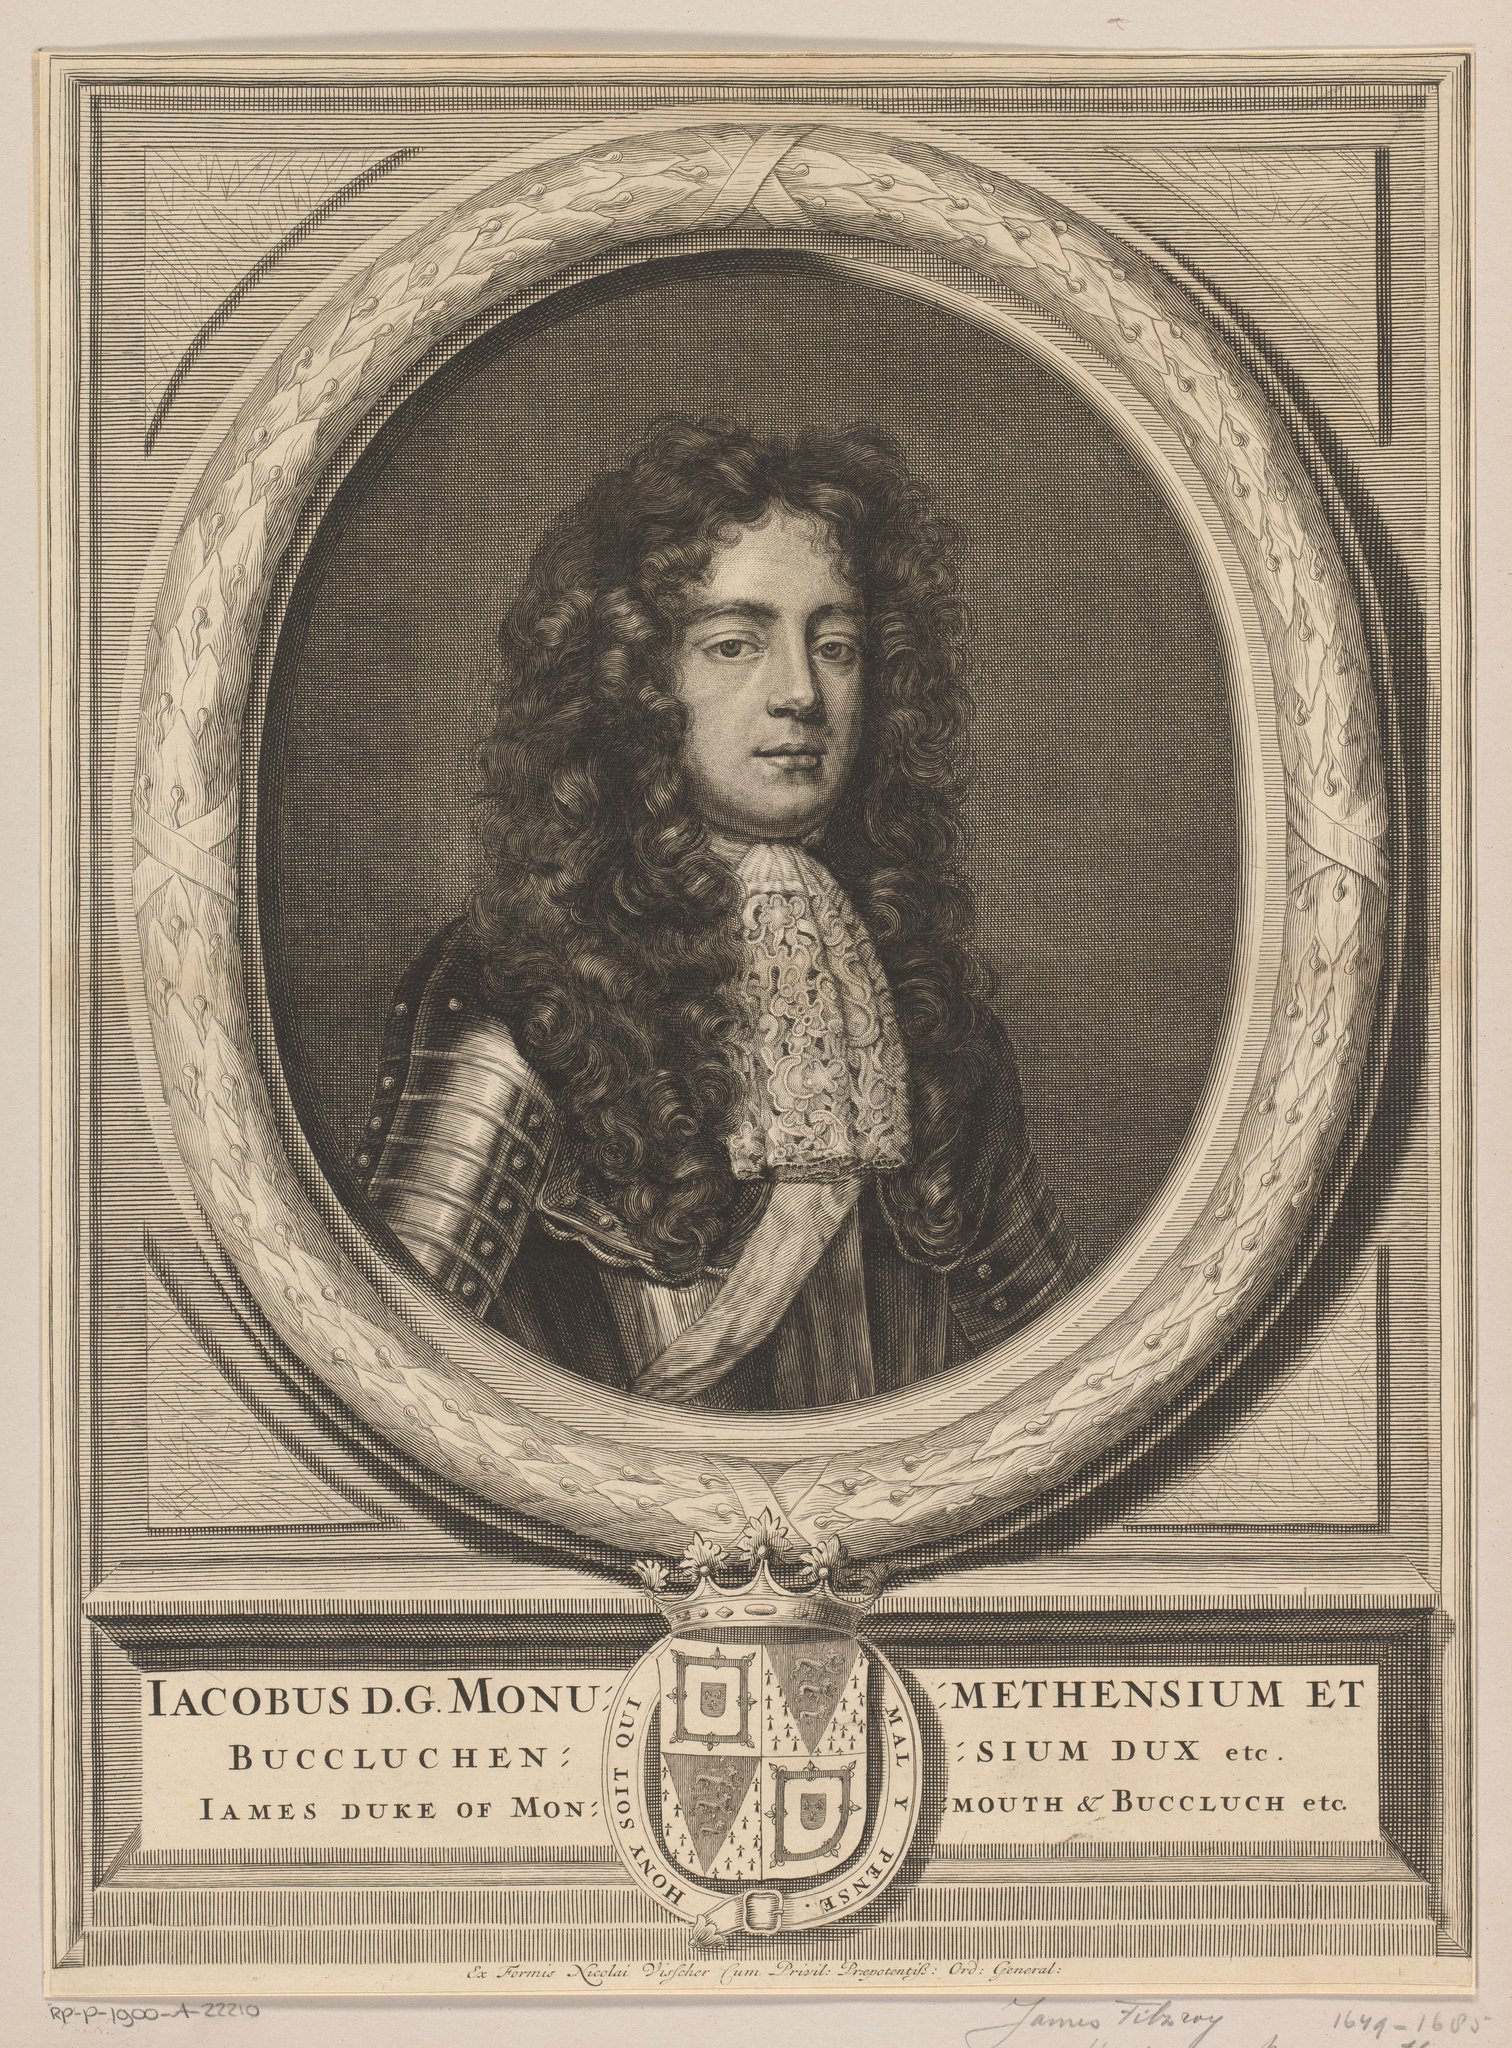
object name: print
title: Portret van James Scott hertog van Monmouth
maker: Anonymous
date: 1633-1702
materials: paper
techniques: engraving, etching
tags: rotterdam, london, armour, historical persons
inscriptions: collector's mark: Lugt 2228